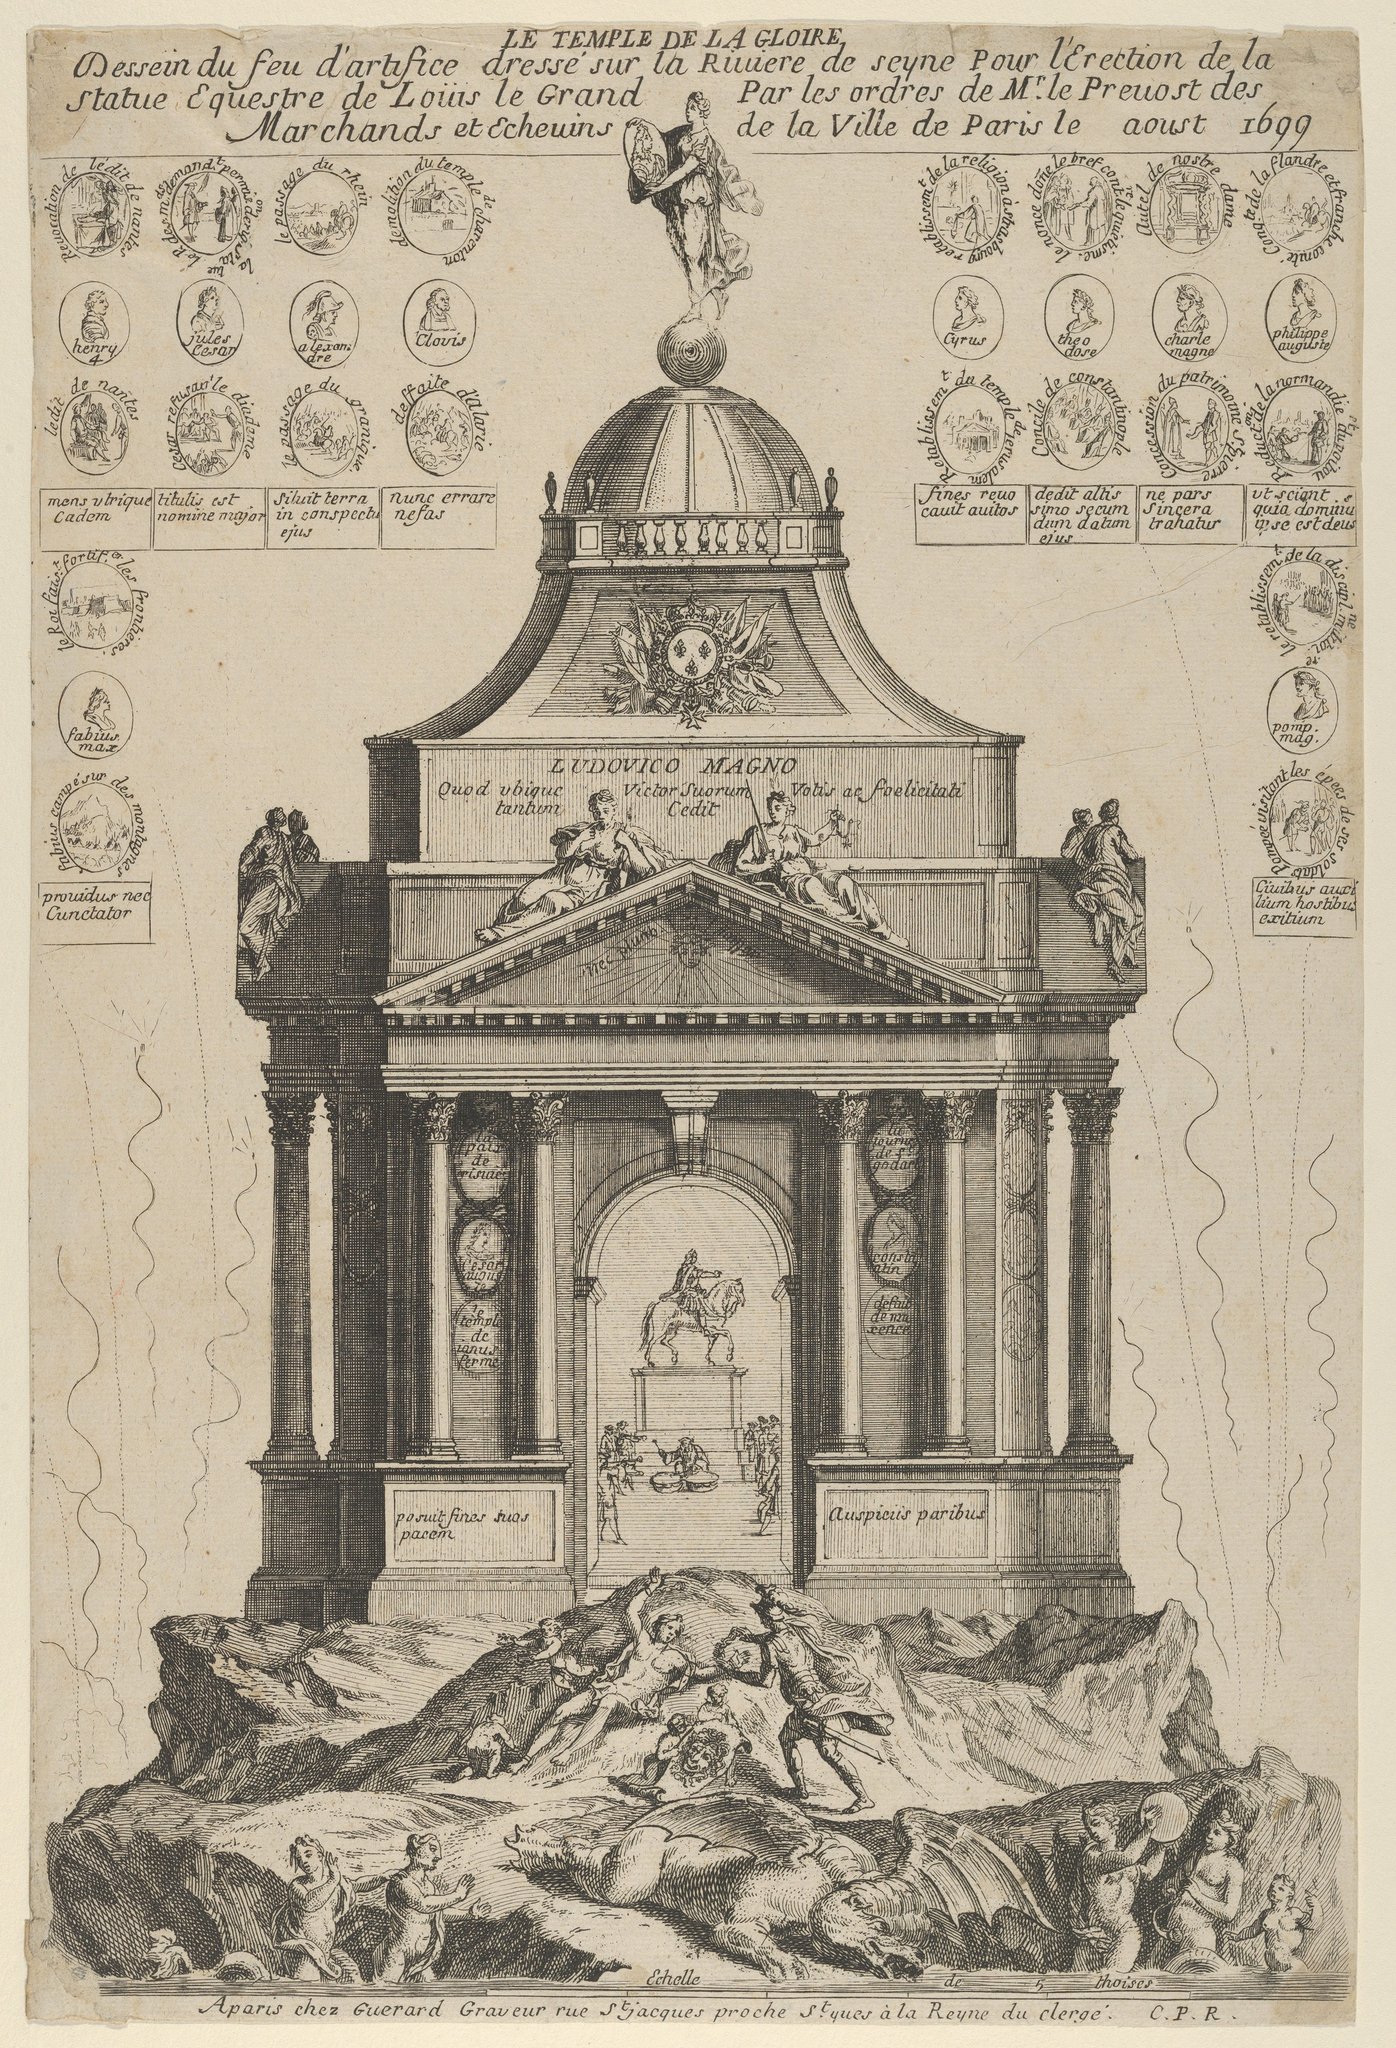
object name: print, fete, ornament architecture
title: Fireworks celebrating the erection of the Temple of Glory and equestrian statue of Louis le Grand, Paris 1699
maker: anonymous, french, 17th century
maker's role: artist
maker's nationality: french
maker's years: 1600-1700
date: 1699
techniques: etching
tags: temples,men,fireworks